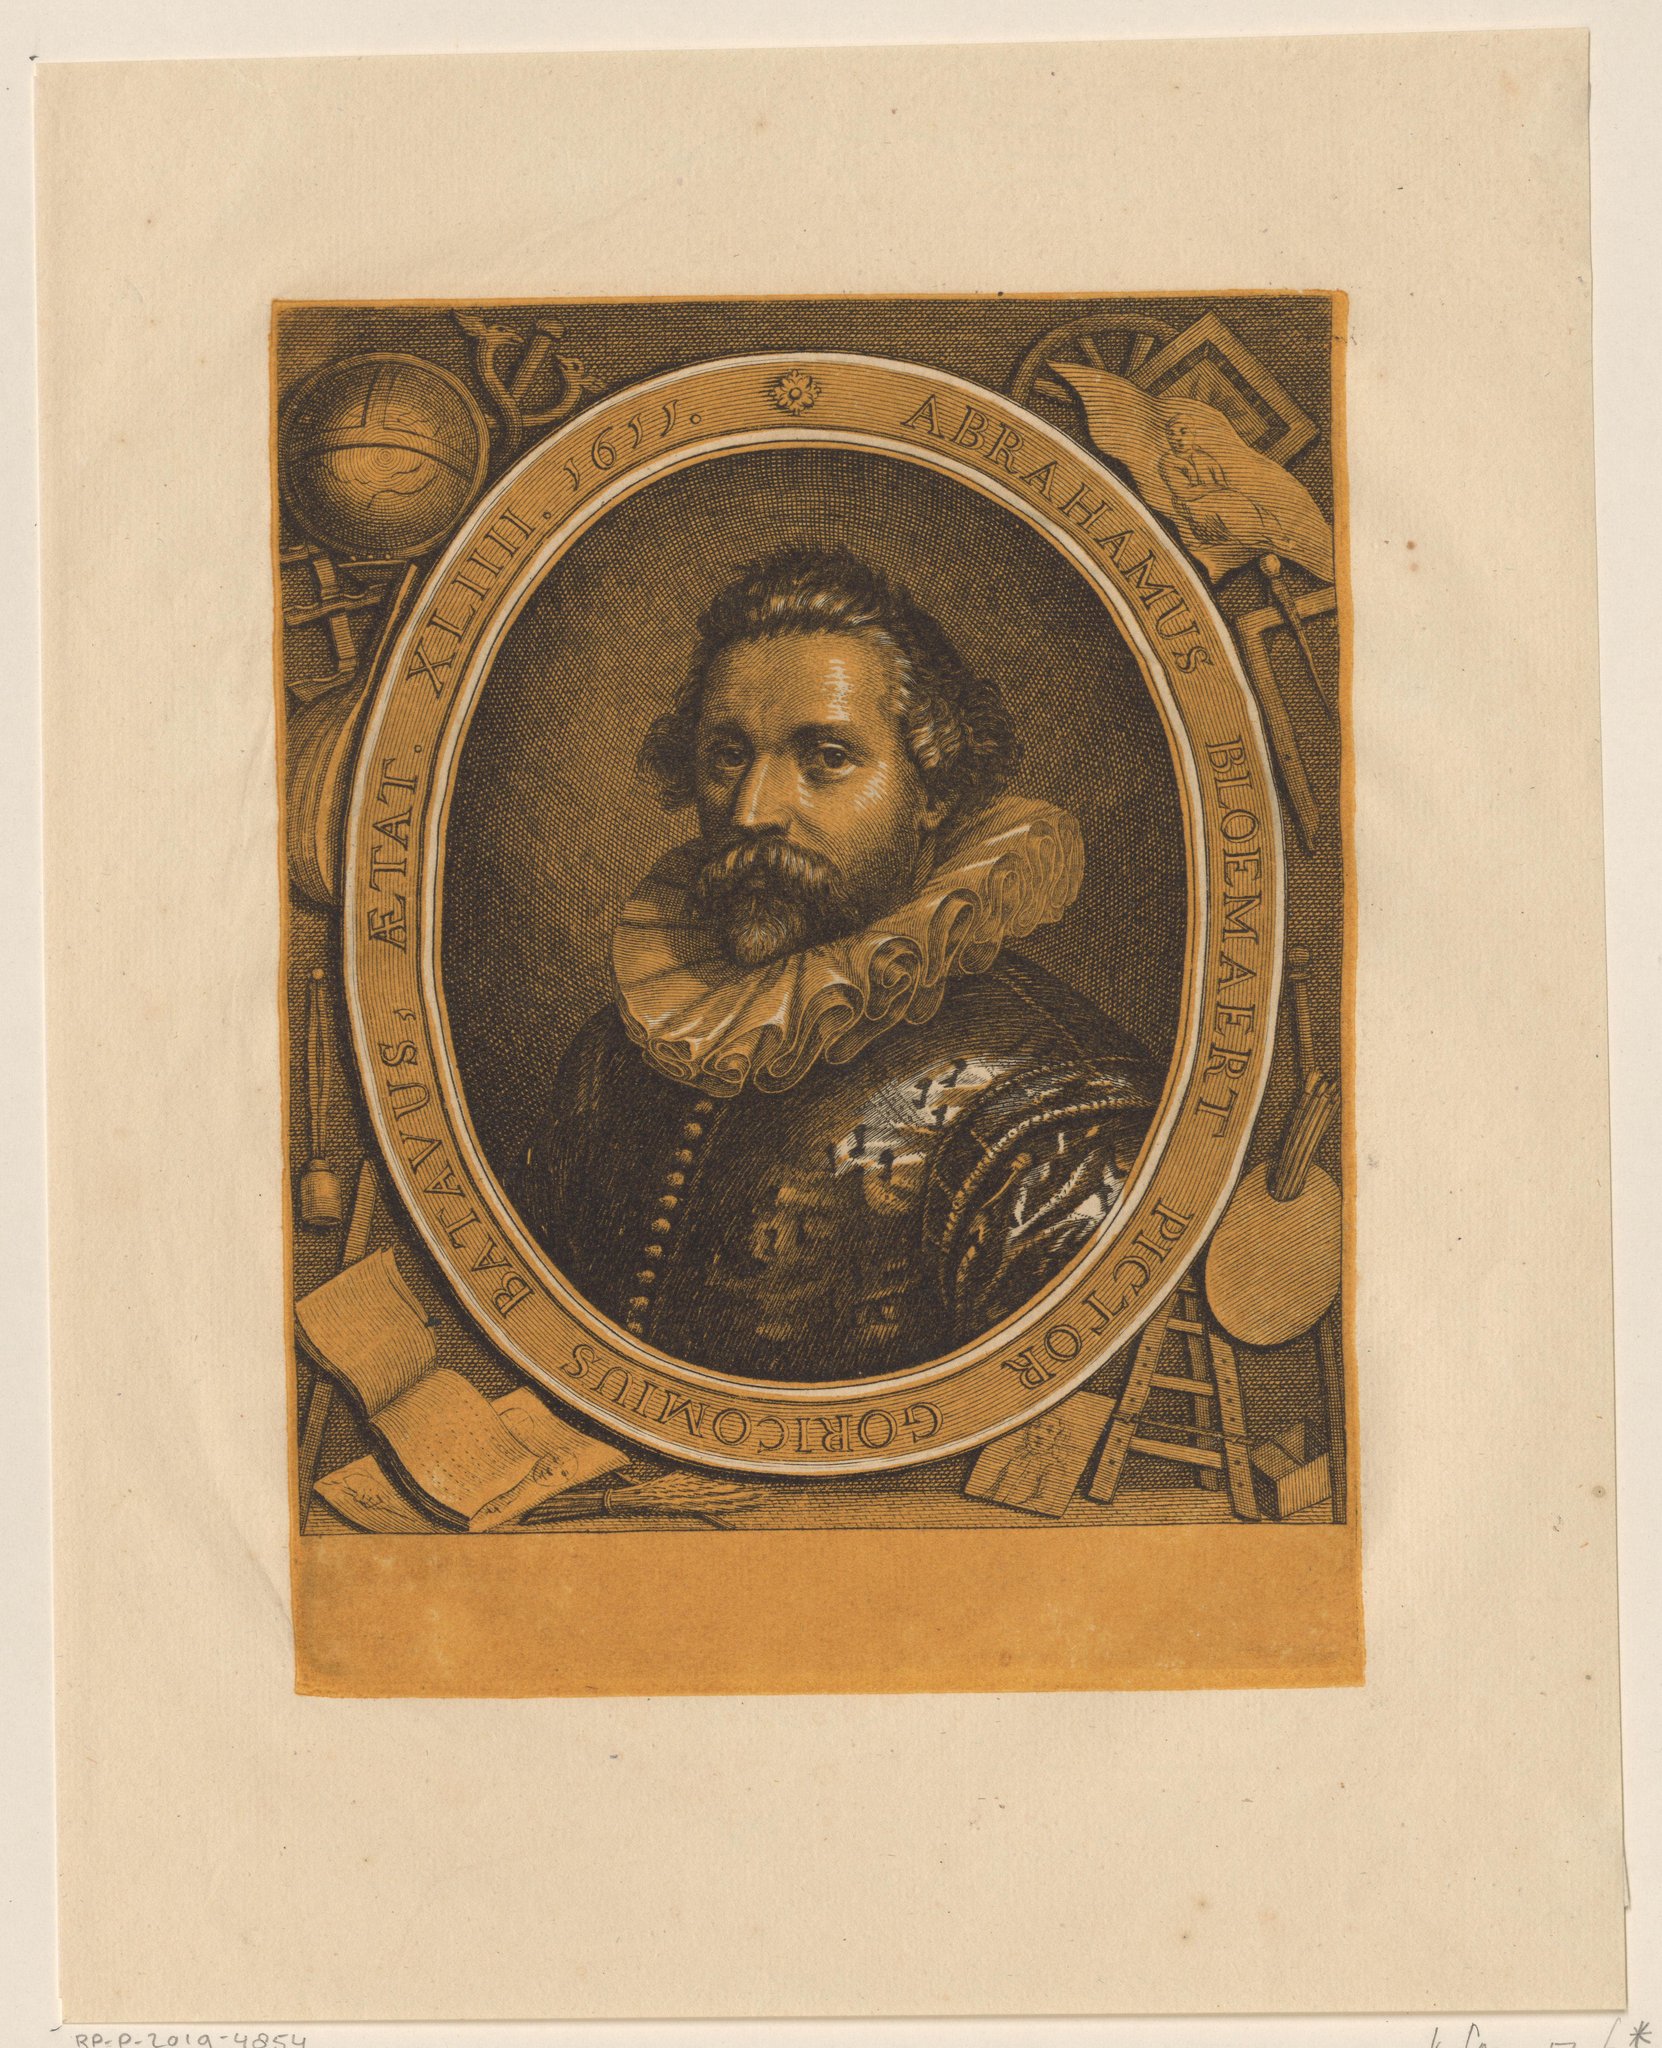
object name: print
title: Portret van Abraham Bloemaert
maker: Anonymous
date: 1650-1699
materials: paper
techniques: engraving, hand coloring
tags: utrecht, painter, print maker, draughtsman, abraham bloemaert, historical persons, portrait, self-portrait of painter, tools, implements of painter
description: Prent met onderschrift gebruikt in: Bloemaert, Abraham. 't Eerste deel van de teeken-konst. [Amsterdam]: Frederik de Wit, s.a.